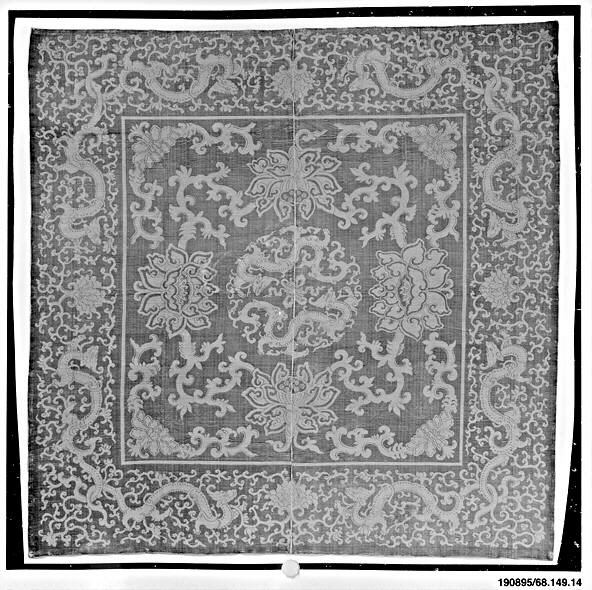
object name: furniture cover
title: Furniture Cover with Lotus and Dragon Scrolls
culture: chinese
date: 1701-1900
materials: silk, velvet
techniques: cutting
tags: dragons,lotuses